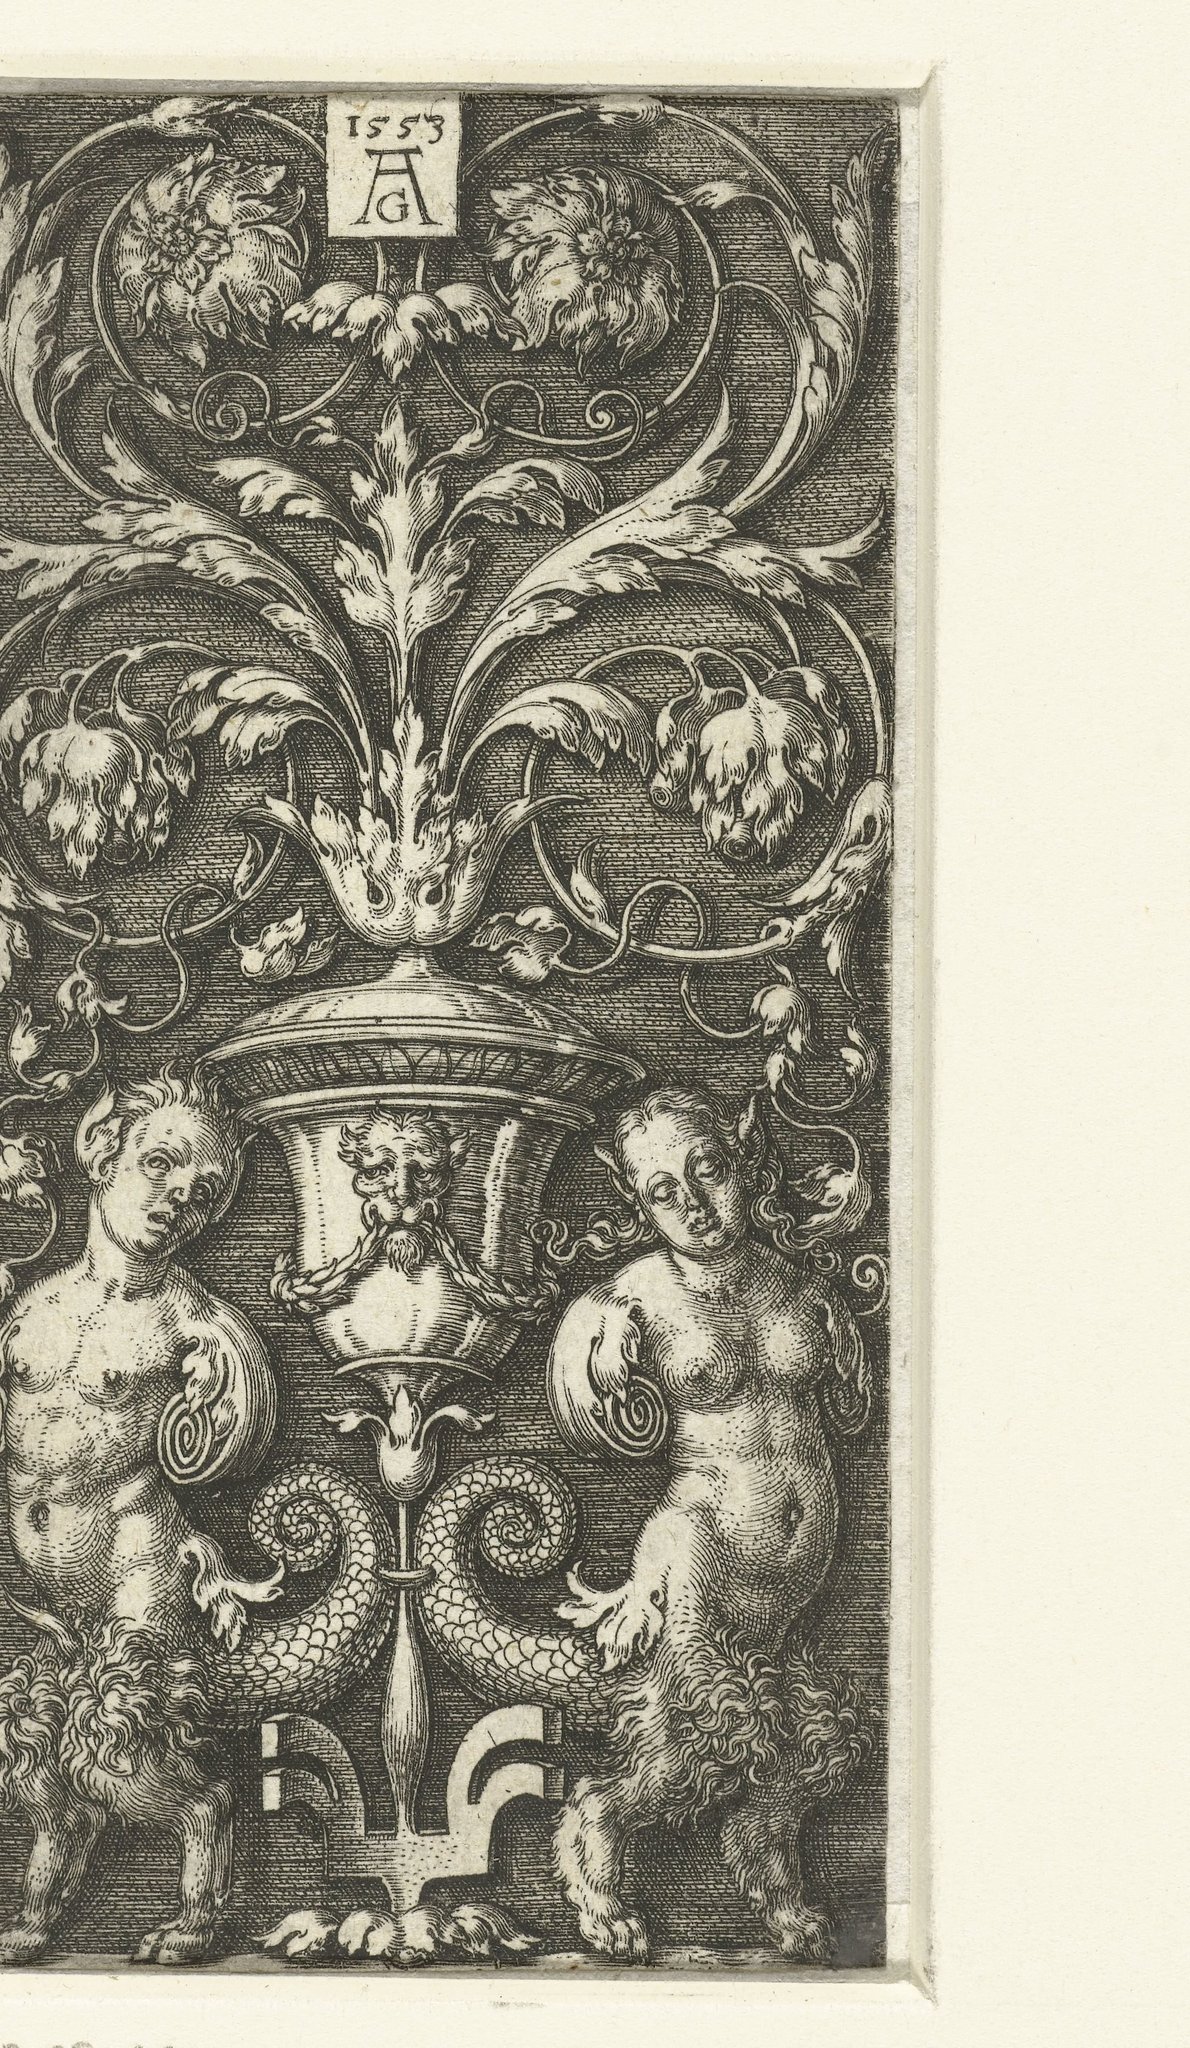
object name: print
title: Vlakdecoratie met twee vrouwelijke saters met vissenstaarten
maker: heinrich aldegrever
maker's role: draughtsman, print maker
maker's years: 1502-1561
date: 1553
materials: paper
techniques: engraving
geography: germany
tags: ornament ~ hybrid beings; human and animal forms mixed, vase ~ ornament, foliage, tendrils, branches ~ ornament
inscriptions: number: ‘25’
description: Vlakdecoratie met bladranken en een vaas met aan weerszijden een vrouwelijke sater met een vissenstraat en voluten als armen.